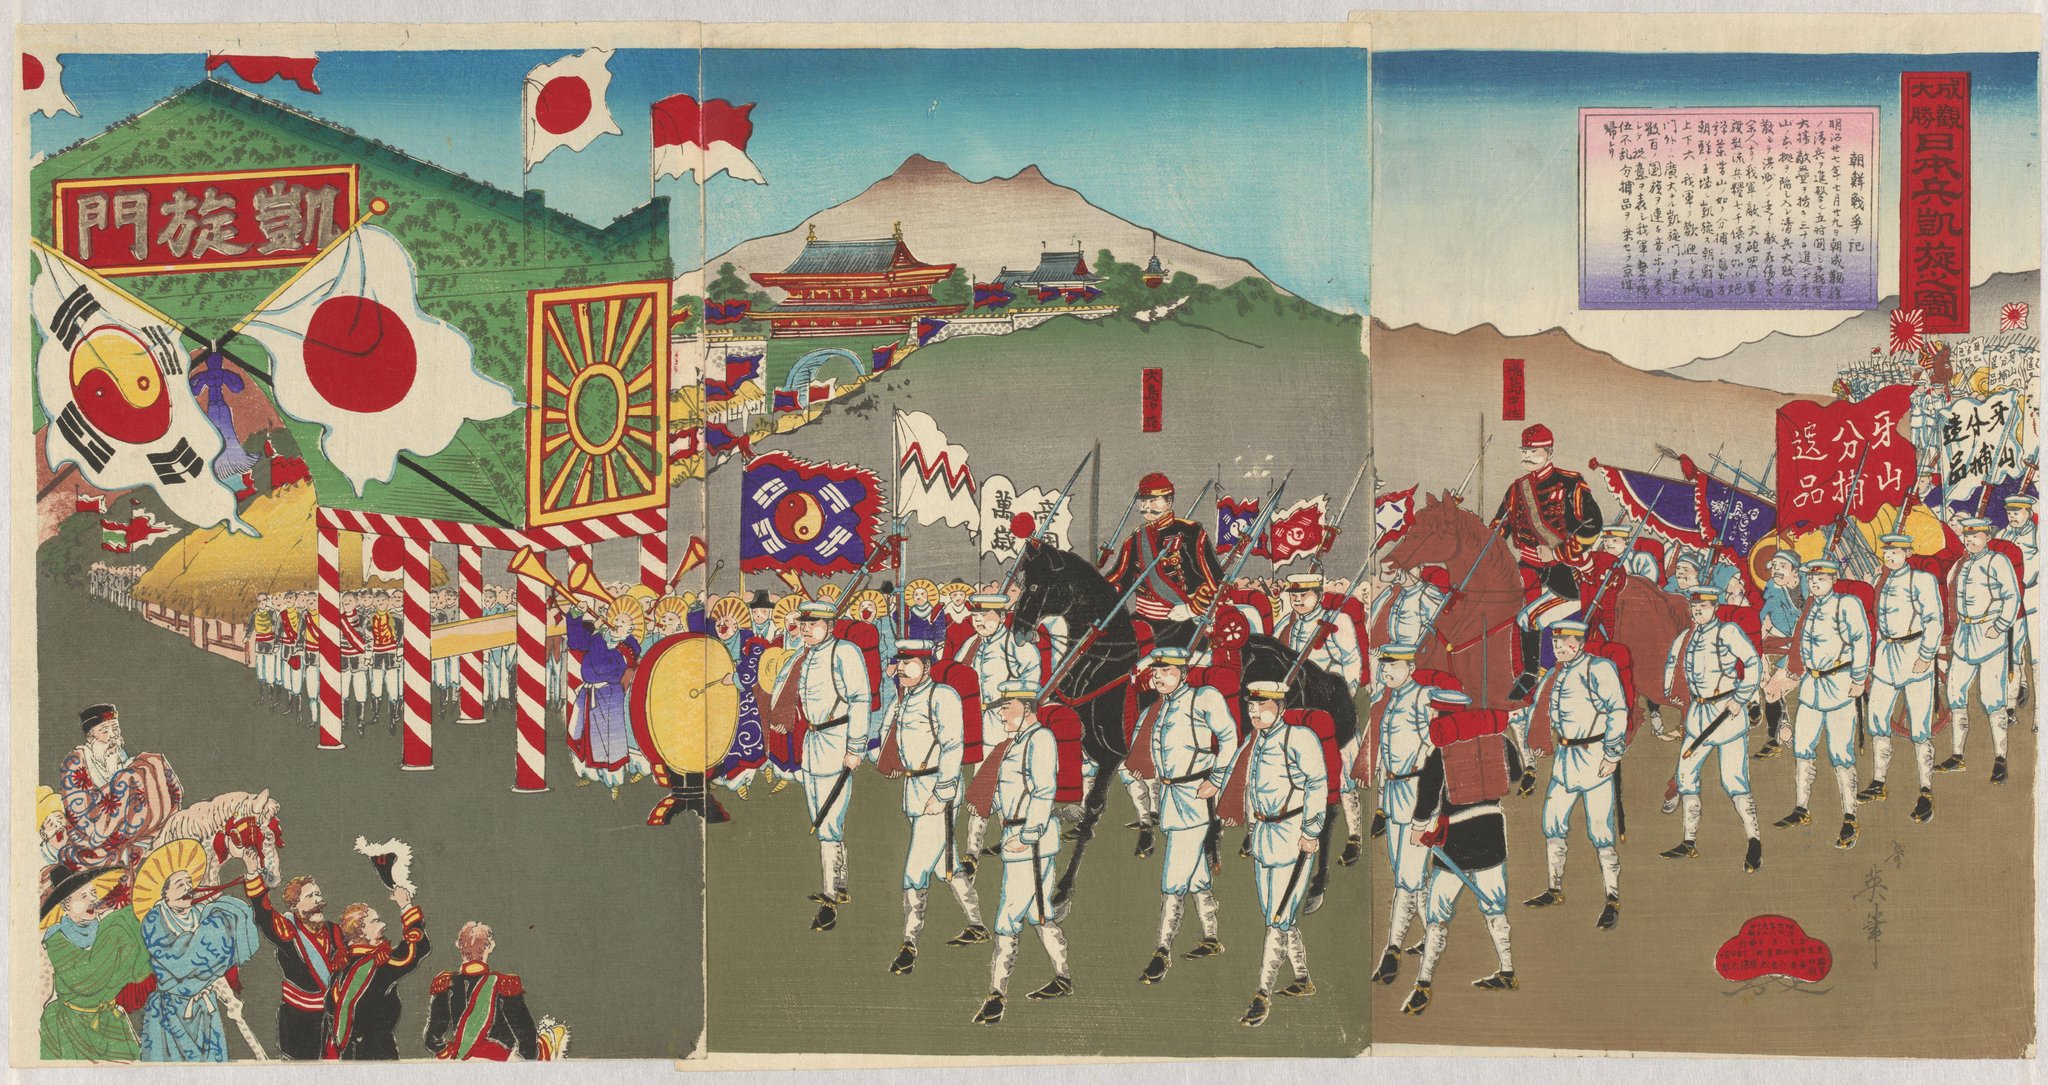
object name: print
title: The Triumphant Return of the Japanese Army after the Great Victory at Seonghwan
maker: kobayashi ikuhide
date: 1894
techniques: woodcut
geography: japan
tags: victory ~ armed conflict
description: After a rebellion among the Korean population in the summer of 1894, the Korean court was compelled to invoke the help of the Chinese army. When Japan became involved, the conflict rapidly escalated. The first fights broke out at the end of July. The Japanese scored a major victory at the Battle of Seonghwan. Here we see their triumphant return to the capital of Seoul.